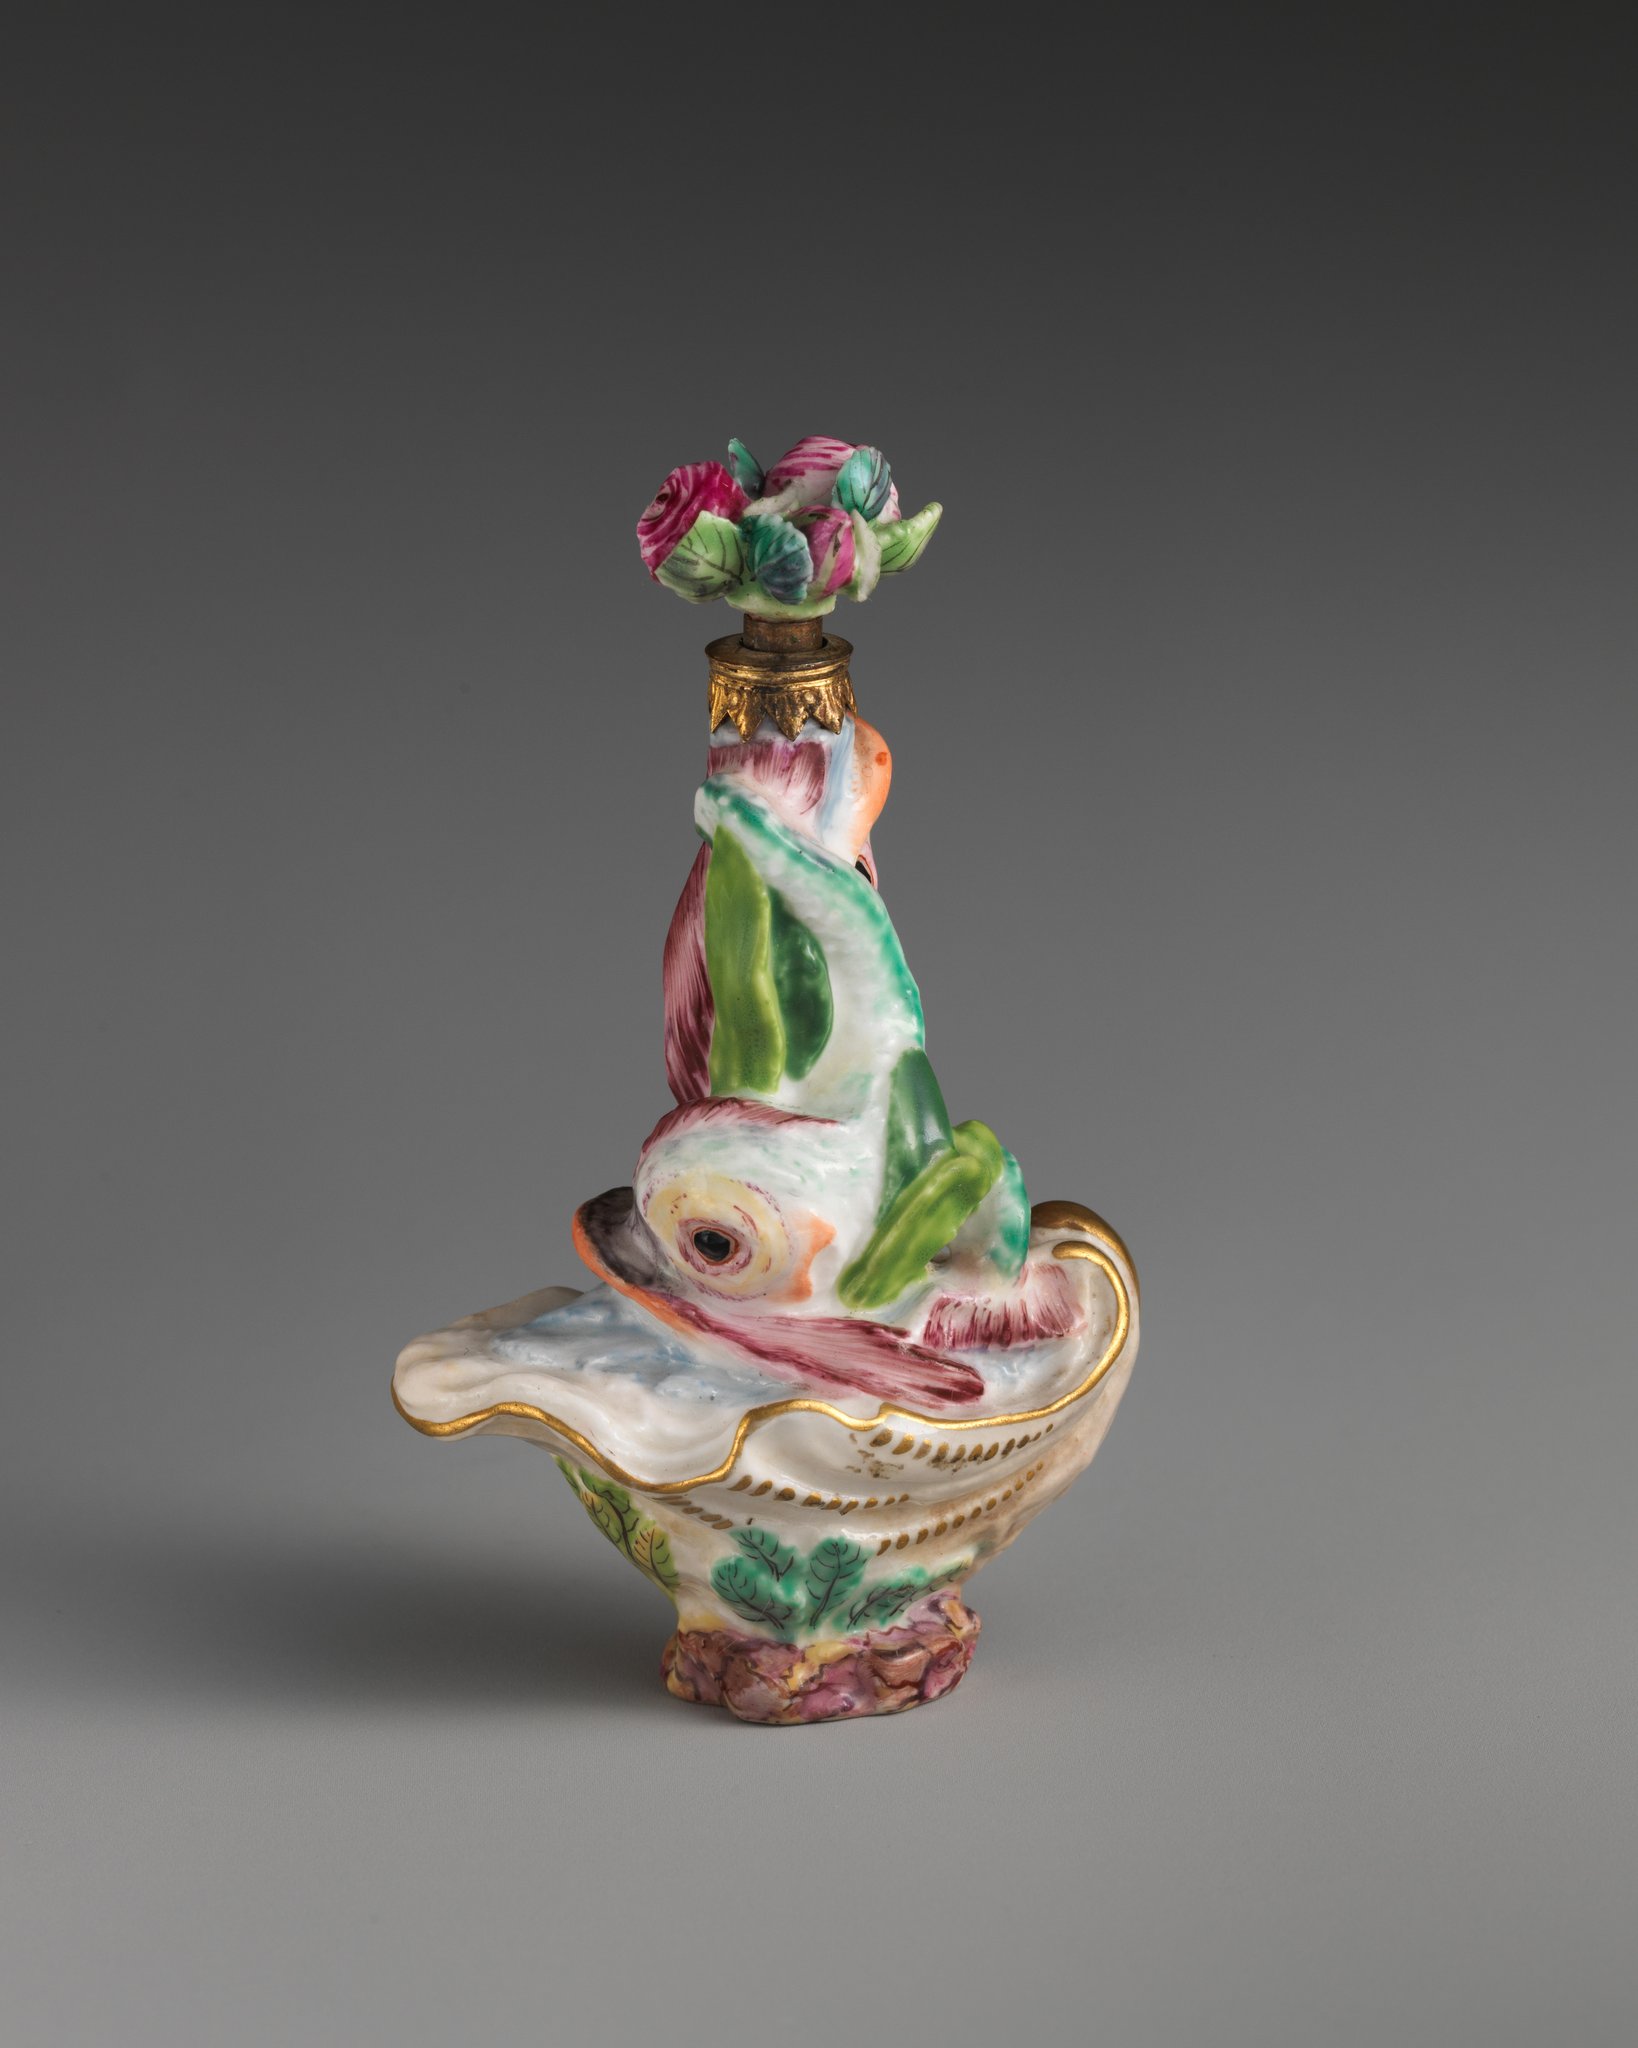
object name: toy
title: Two entwined dolphins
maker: chelsea porcelain manufactory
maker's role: factory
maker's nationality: british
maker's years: 1744-1784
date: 1753-1758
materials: soft paste porcelain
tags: dolphins